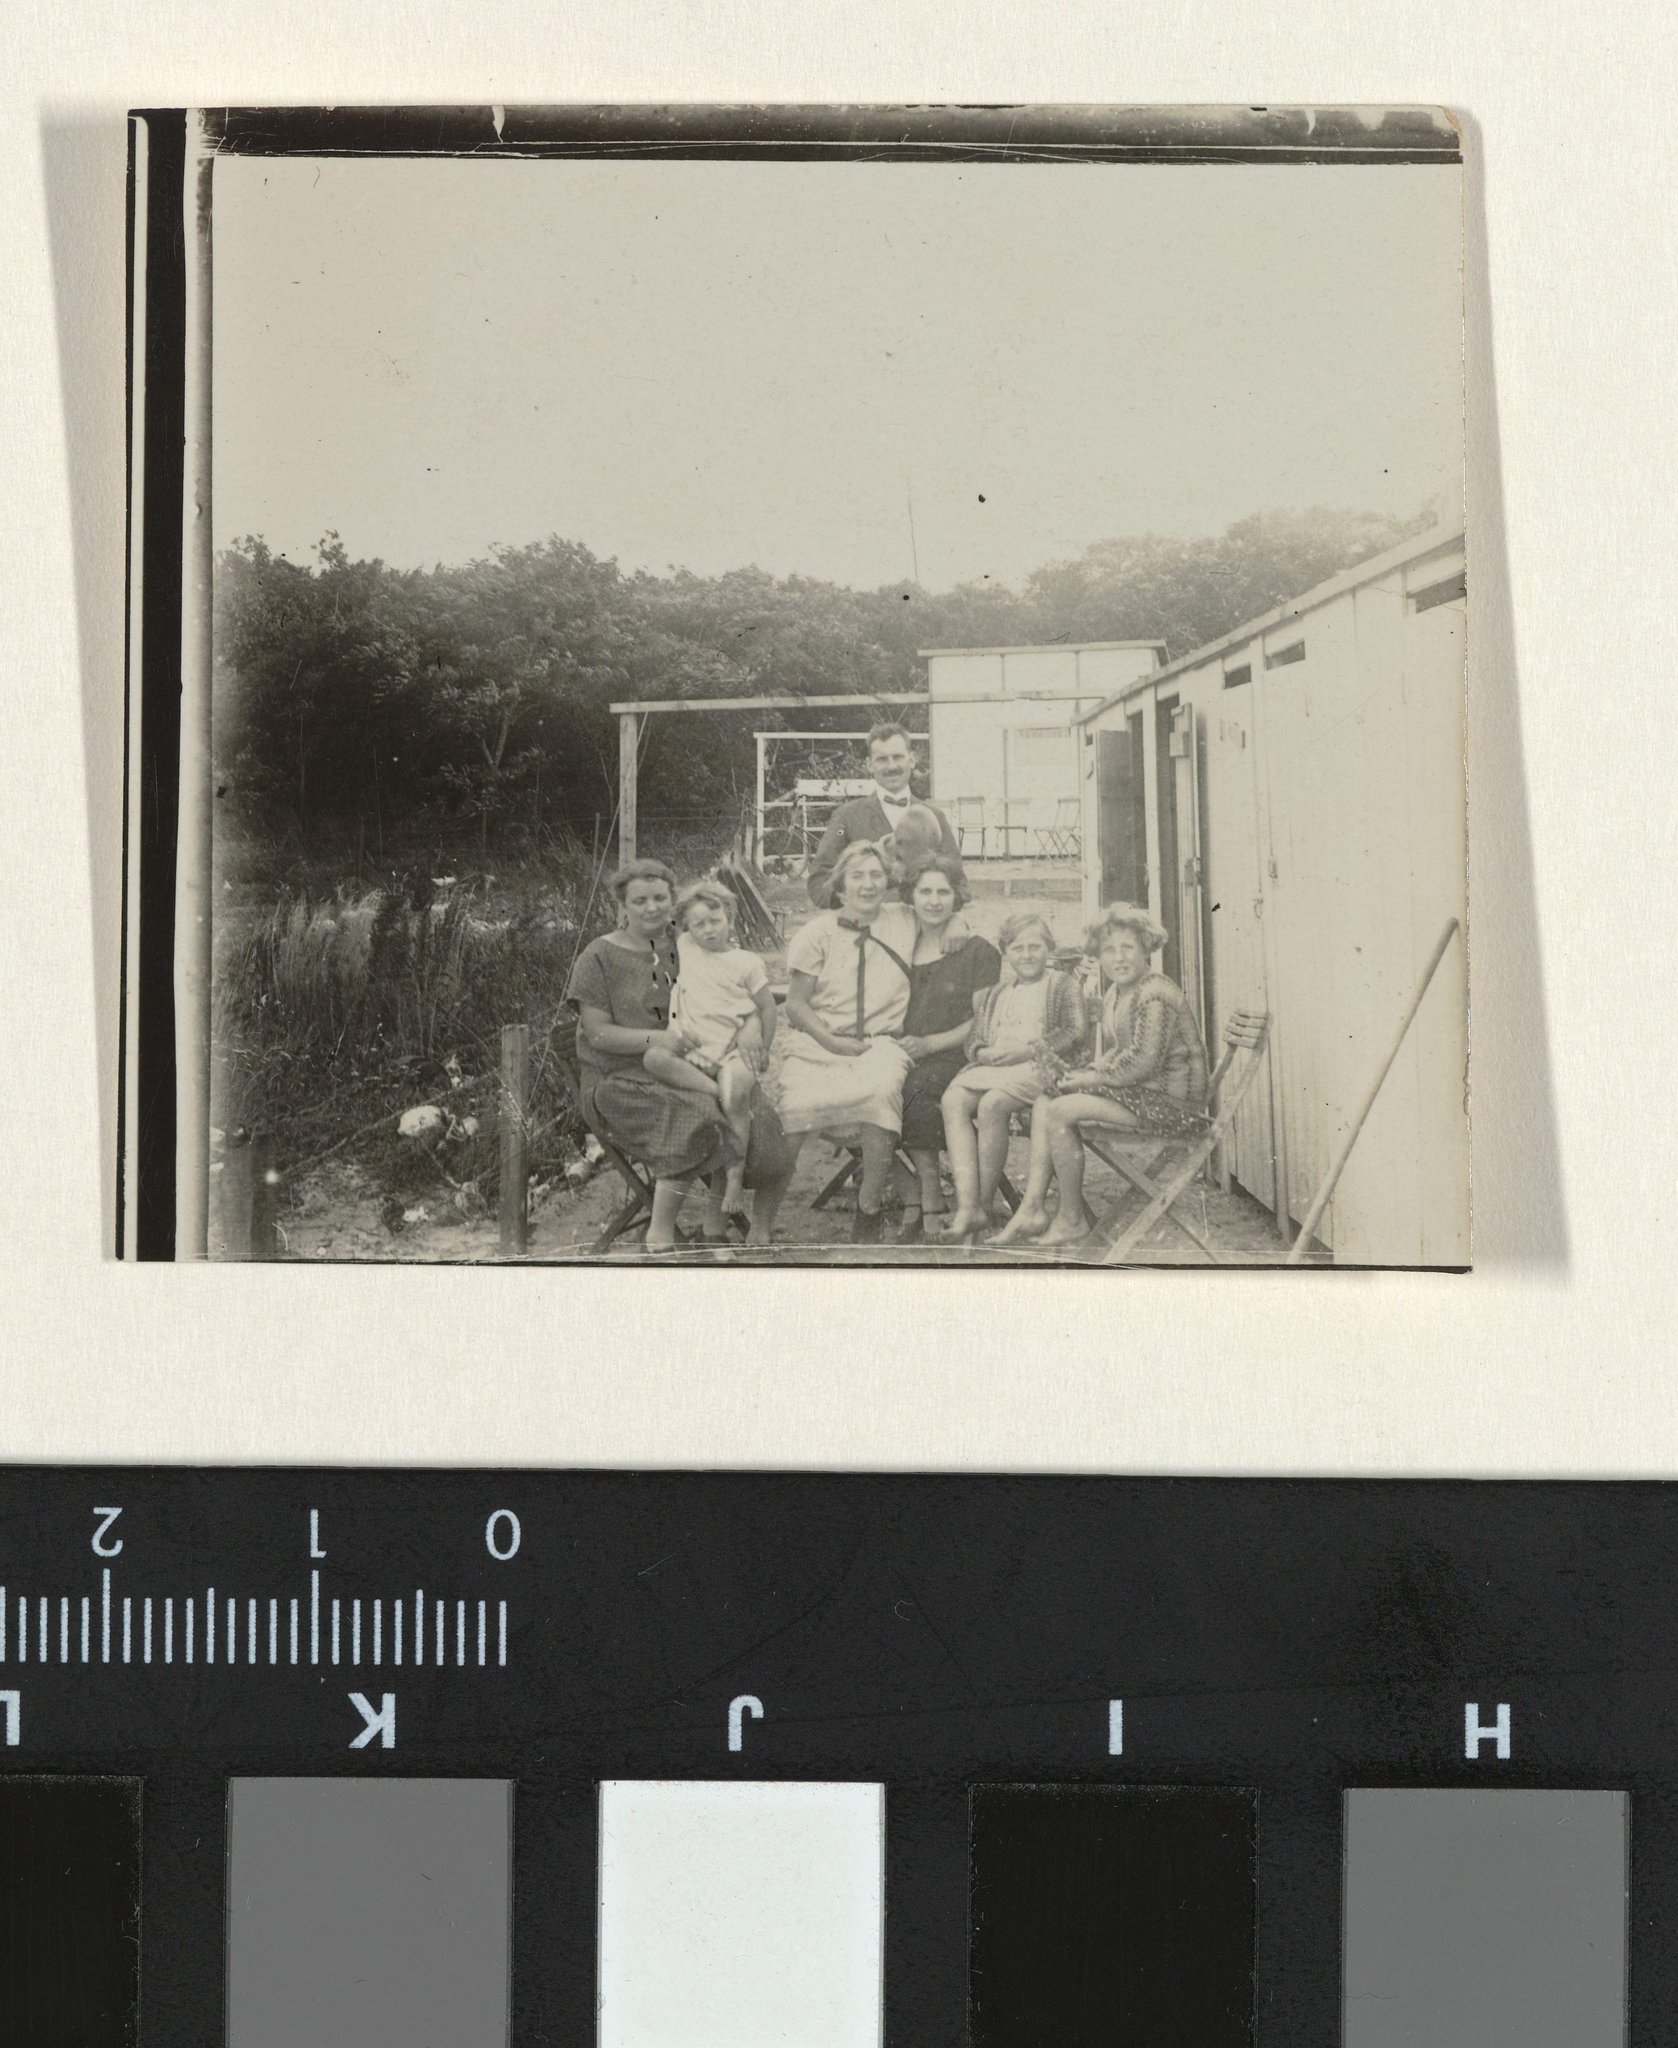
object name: photograph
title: Groep mensen naast een rij kleedkamers op het strand bij De Wijde Blik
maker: Anonymous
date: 1925-1935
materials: paper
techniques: gelatin silver print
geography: valkeveen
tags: beach (as place of recreation)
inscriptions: inscription: ‘AD’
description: Portret van een groep mensen poserend naast een rij badhokjes (Vinkeveen?).